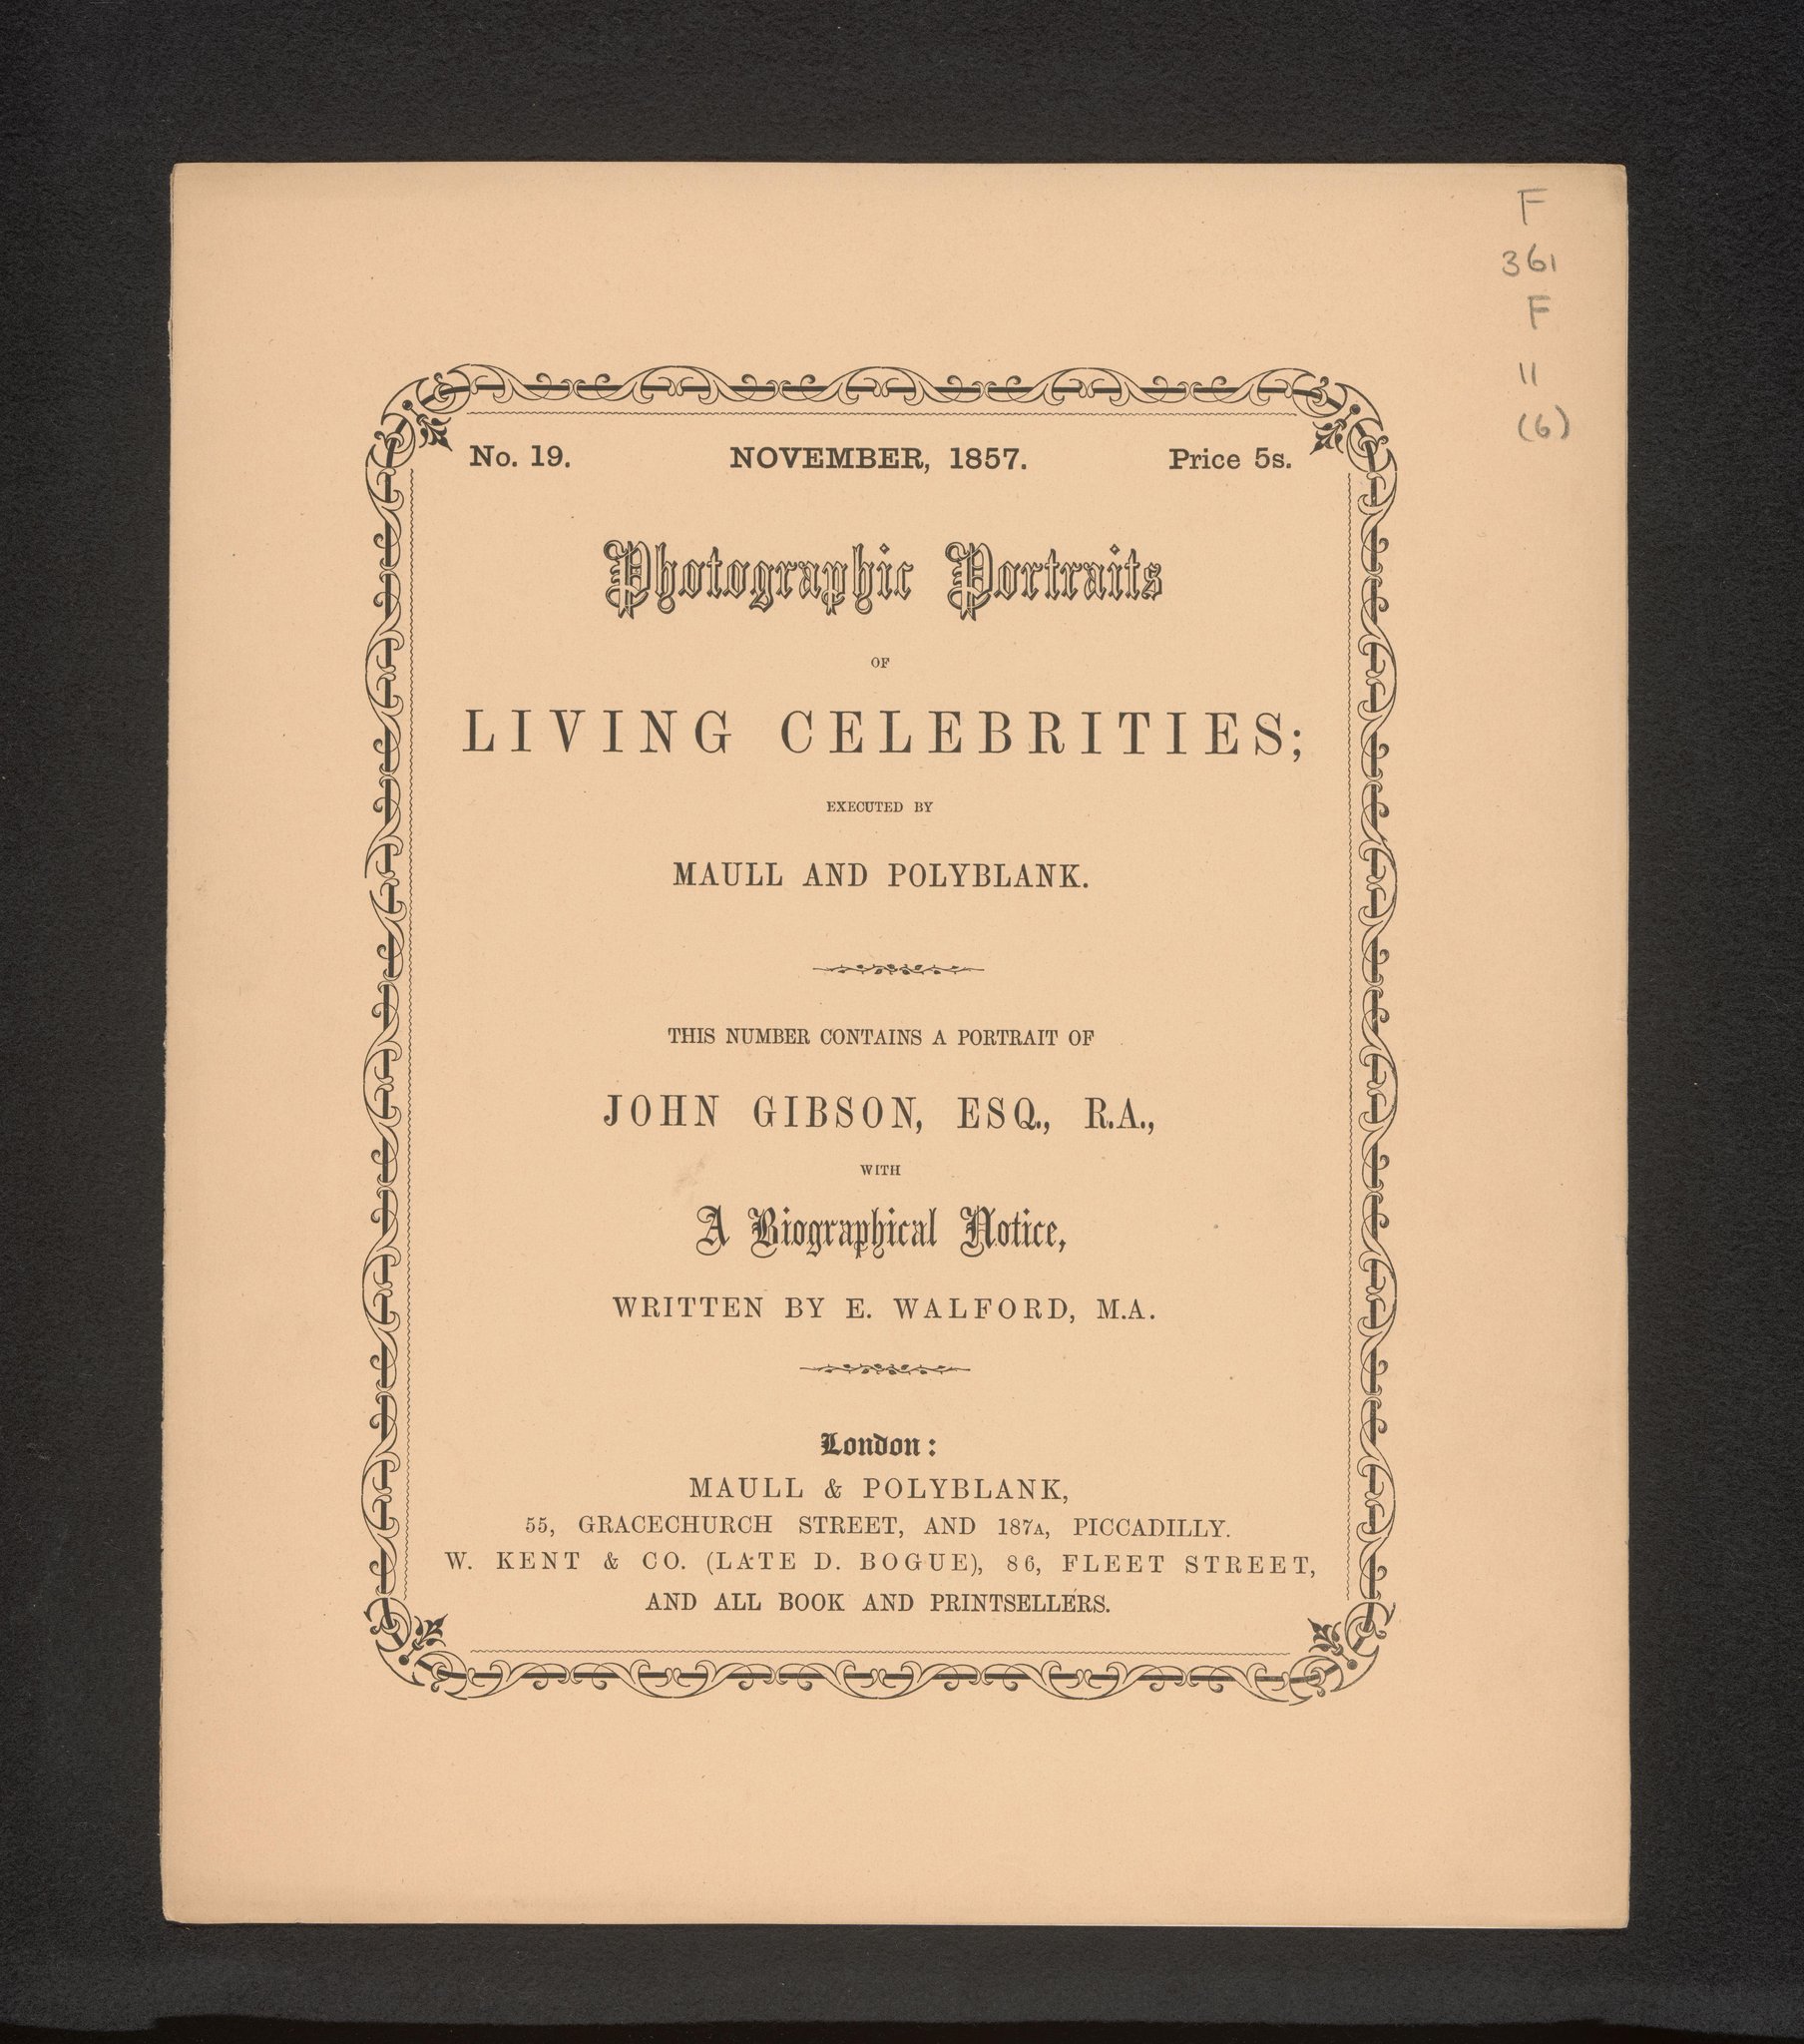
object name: wrapper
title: Photographic Portraits of Living Celebrities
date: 1857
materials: paper, photographic support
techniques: albumen print, printing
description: Omslag met drie bladzijden, waarvan een met een foto.